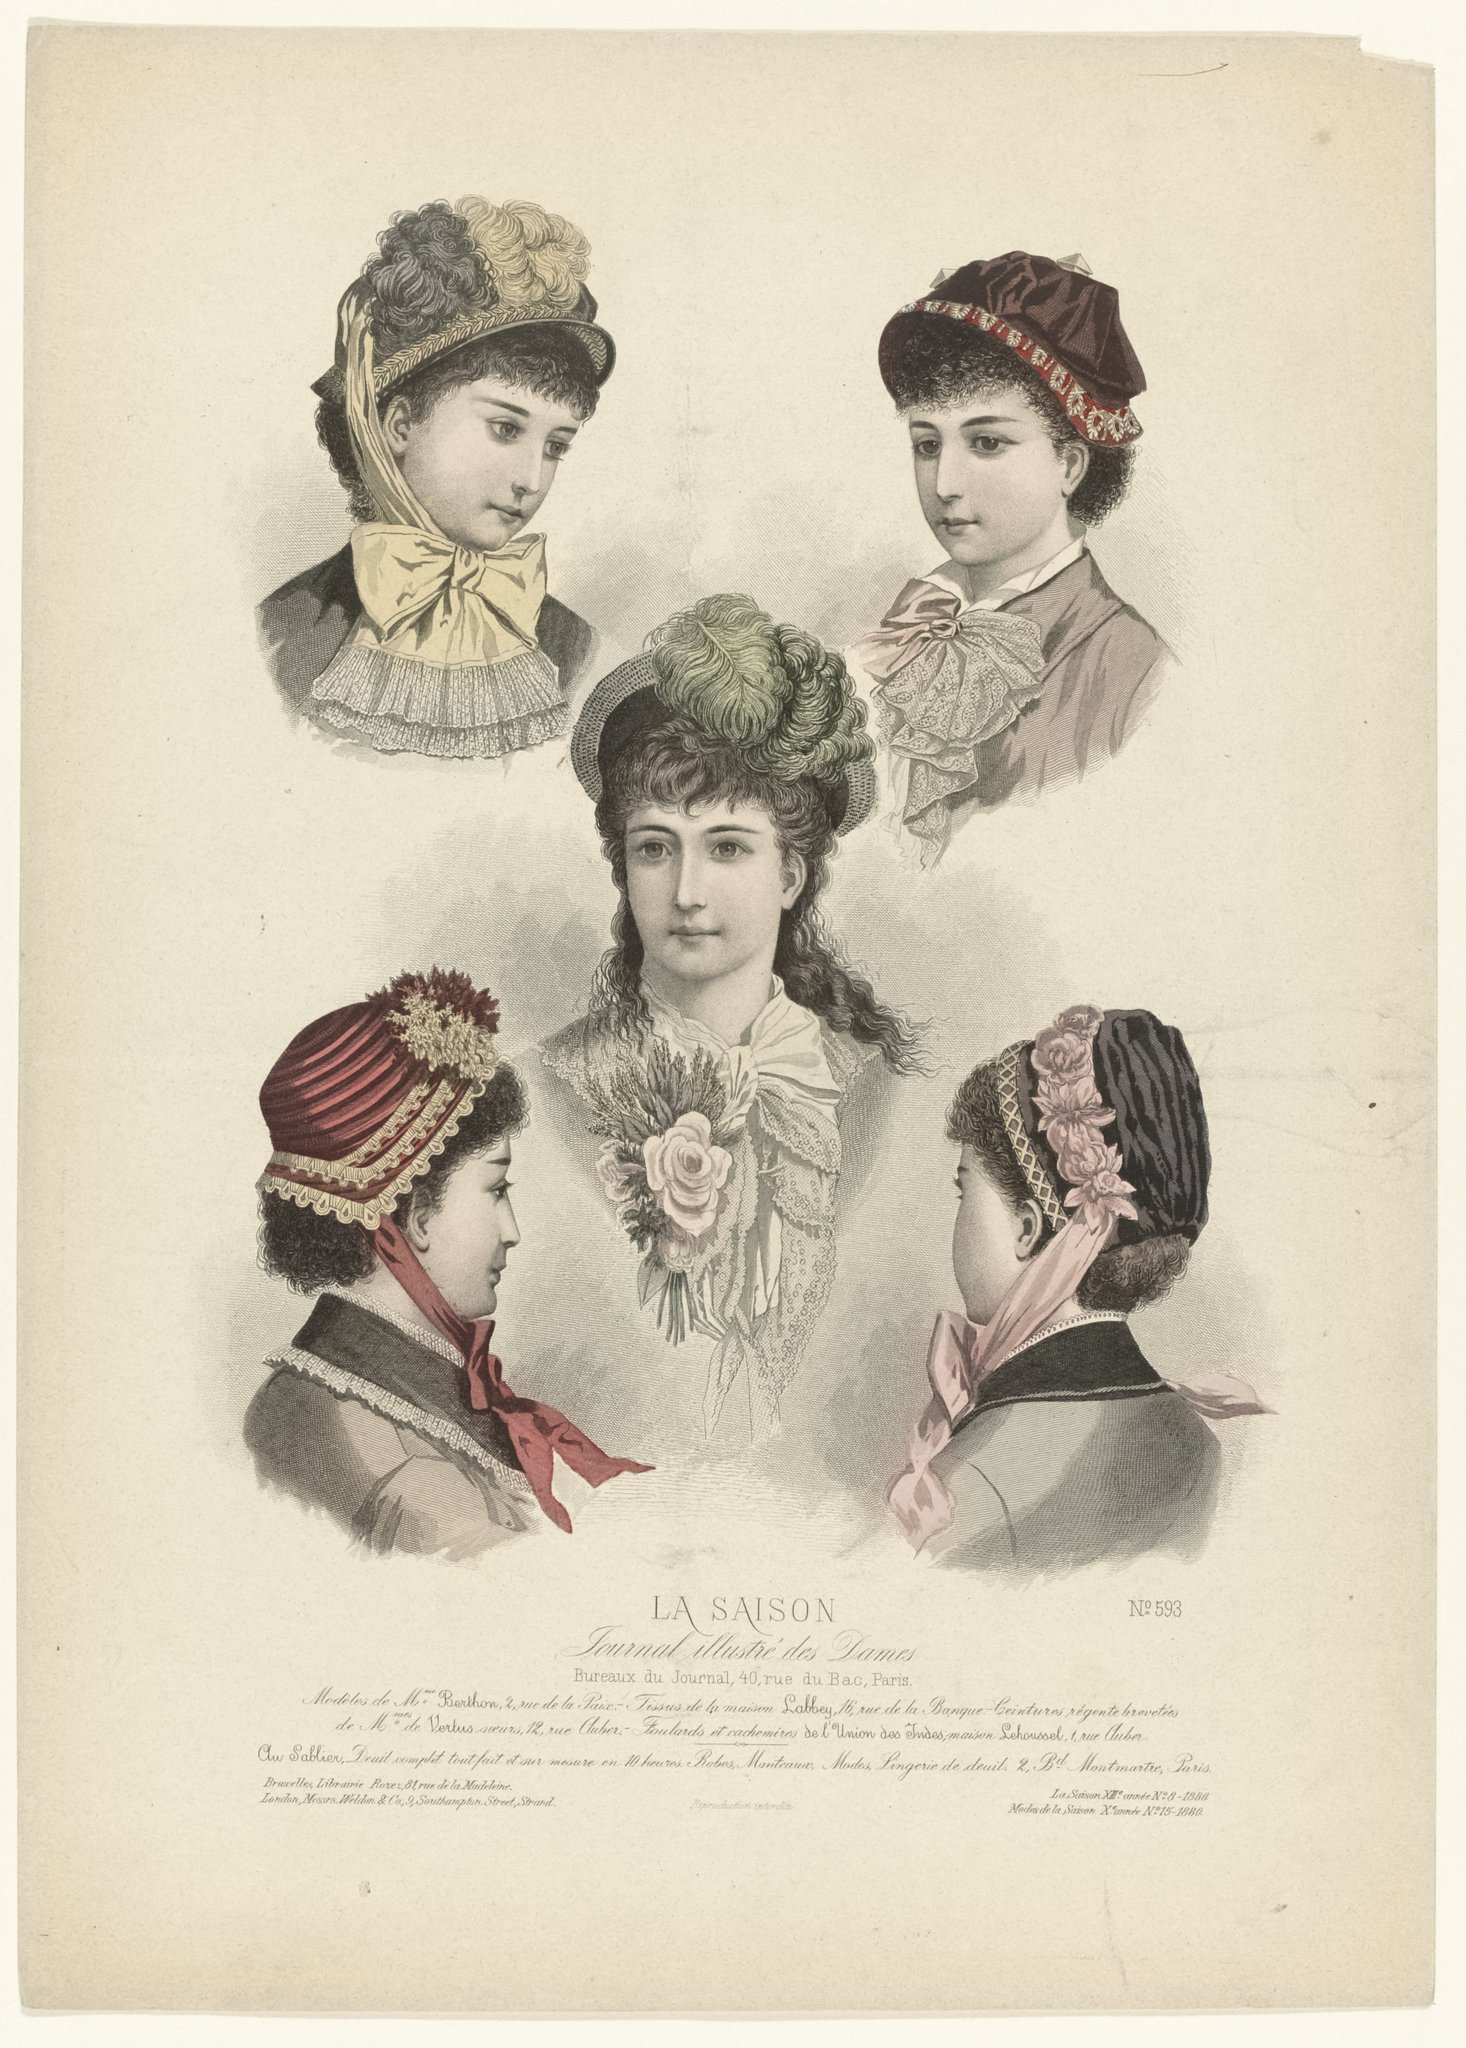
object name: fashion print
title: La Saison, Journal illustré des Dames, 1880, 13e année, No. 8, No. 593: Modèles de Mme Berthon (...)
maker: Anonymous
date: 1880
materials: paper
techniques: engraving, hand coloring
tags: corsage (+ women's clothes), flowers, border, ribbon, braid (+ women's clothes), fashion plates, head-gear: hat (+ women's clothes)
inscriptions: address: ‘Bureaux du Journal, 40, rue du Bac, Paris.’, address: ‘Bruxelles, Librairie, Rozez, 81, rue de la Madeleine. London, Messrs. Weldon & Co, 9, Southampton Street, Strand.’, caption: ‘Modèles de M.me Berthon, 2, rue de la Paix. - Tissus de la maison Labbey, 16, rue de la Banque . - Ceintures régente brevetées de Mmes de Vertus soeurs, 12, rue Auber. - Foulards et cachemires de l'Union des Indes, maison Lehoussel, 1, rue Auber / Au Sablier, Deuil complet tout fait et sur mesure en 10 heures. Robes, Manteaux, modes, Lingerie de deuil, 2, Bd Montmartre, Paris.’, title: ‘LA SAISON / Journal illustré des Dames’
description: Vijf vrouwenhoofden met verschillende hoeden. Volgens het onderschrift: 'modèles' van Berthon. Hieronder enkele regels reclametekst voor verschillende producten. Prent uit de modetijdschriften(?) La Saison (1867-1902) en Les Modes de la Saison (1871-1885).